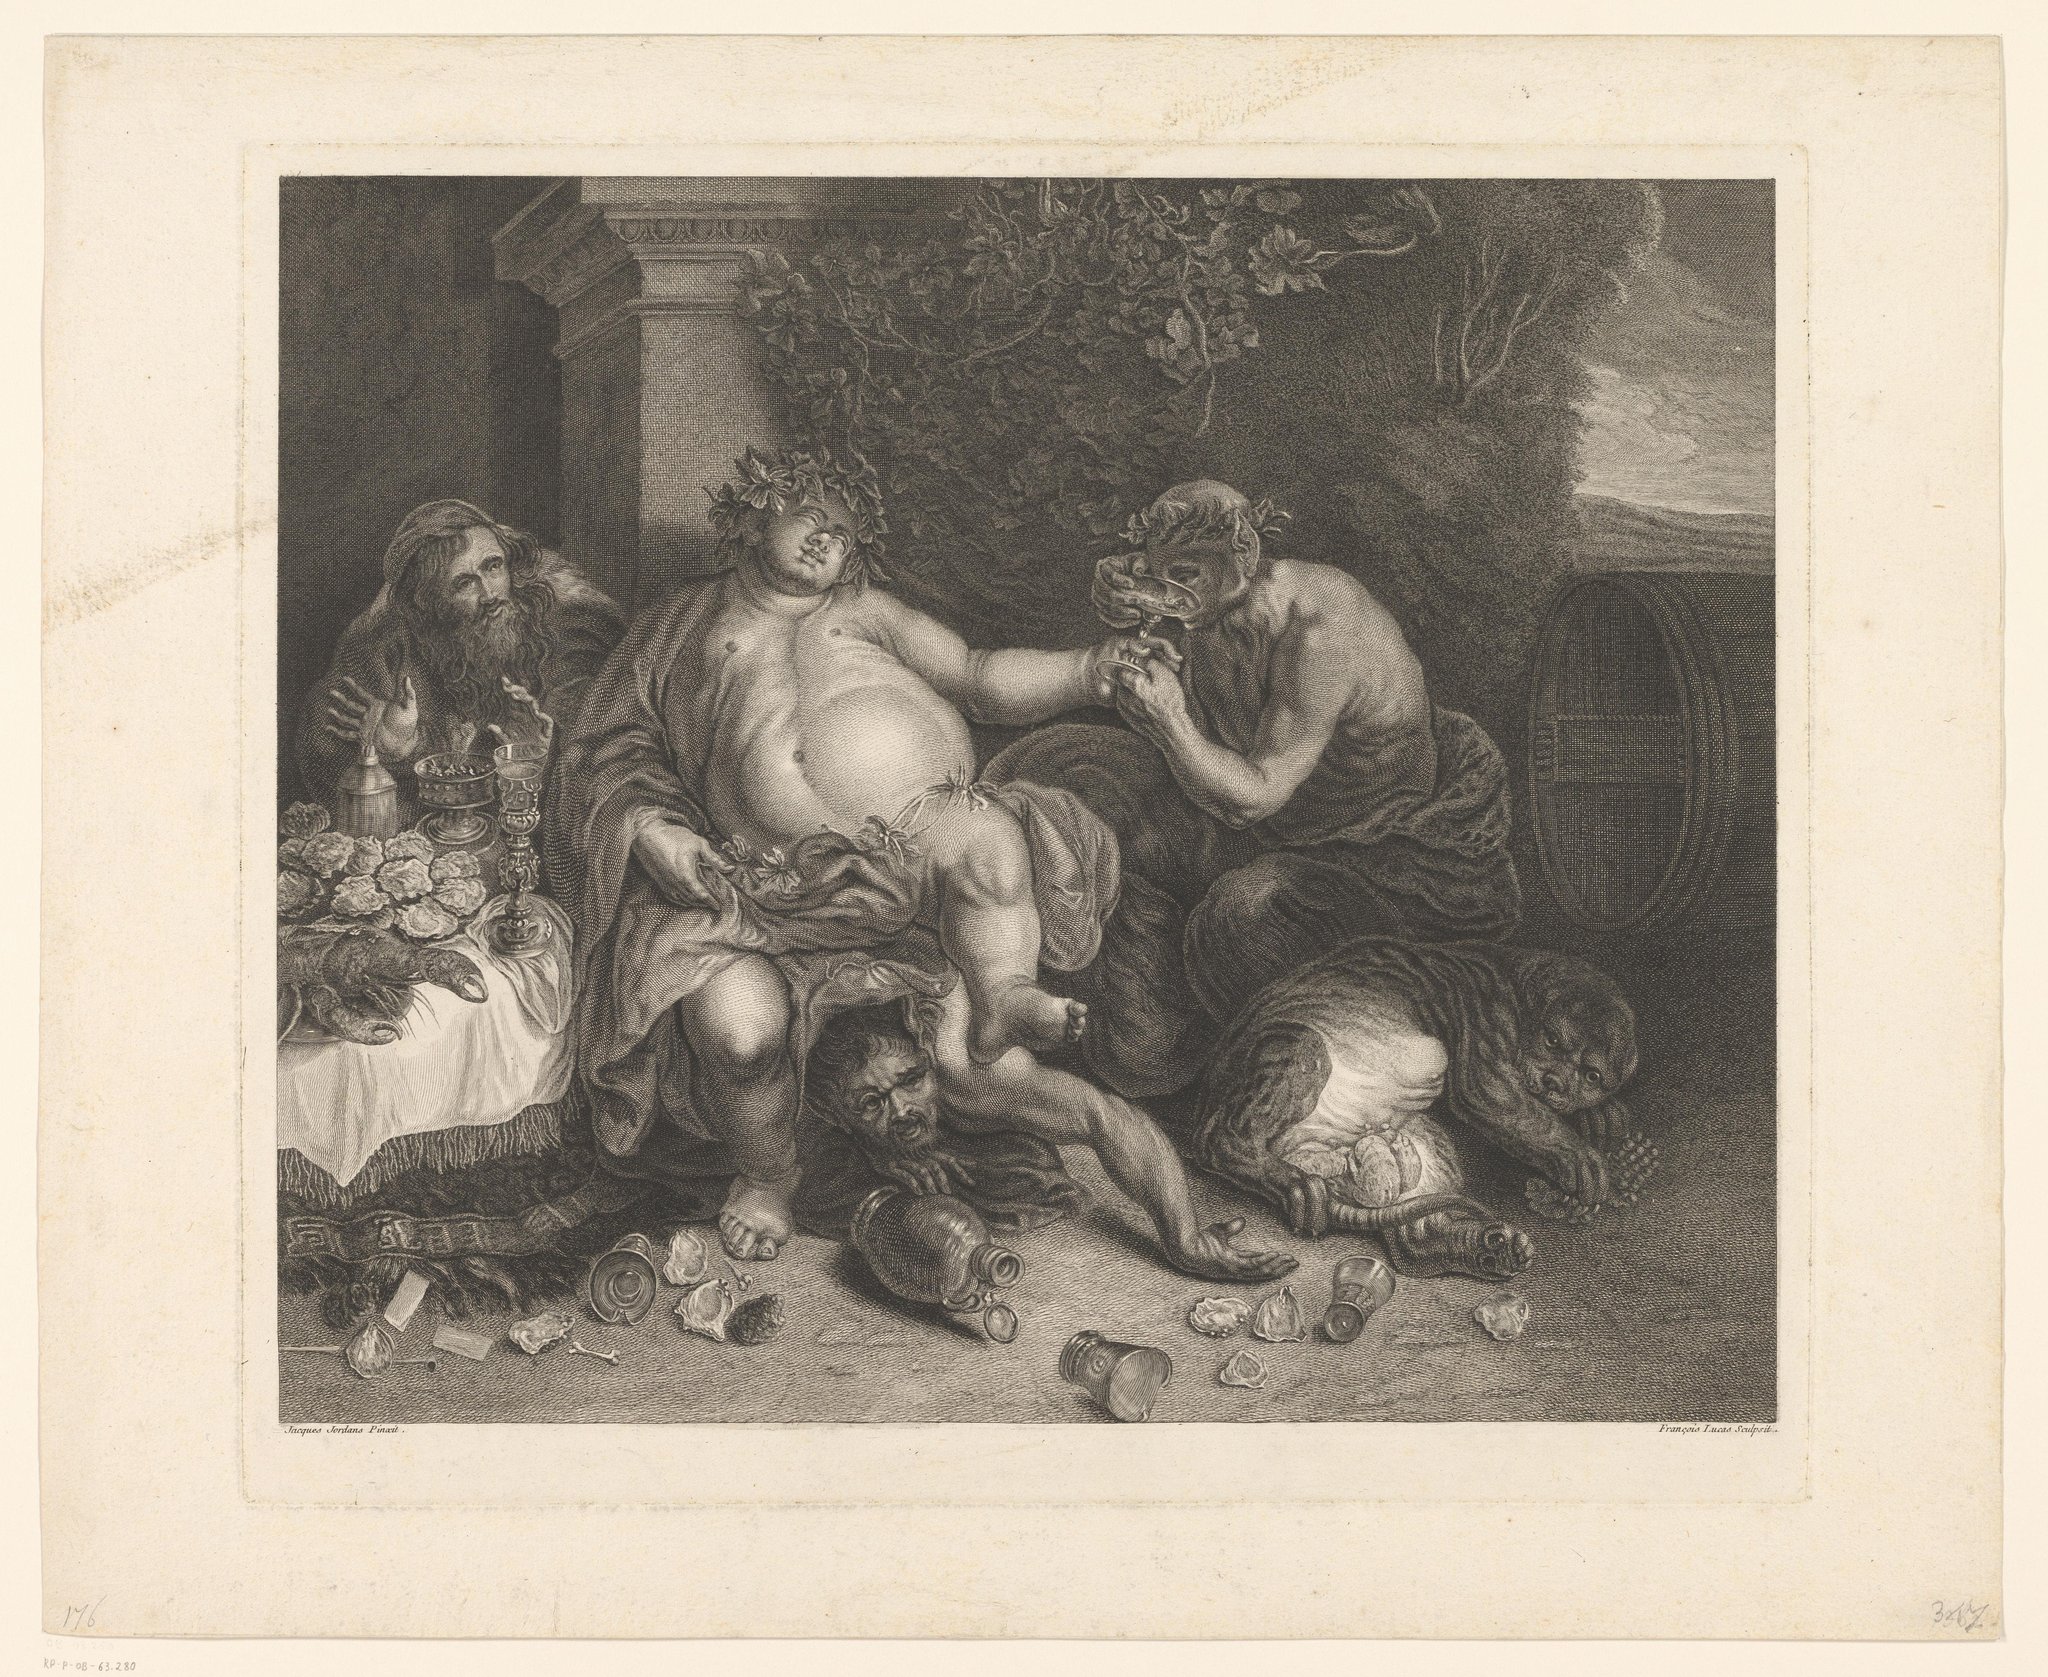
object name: print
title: Bacchanaal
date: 1725-1762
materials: paper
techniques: engraving, etching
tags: the drunken bacchus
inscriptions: collector's mark: Lugt 240